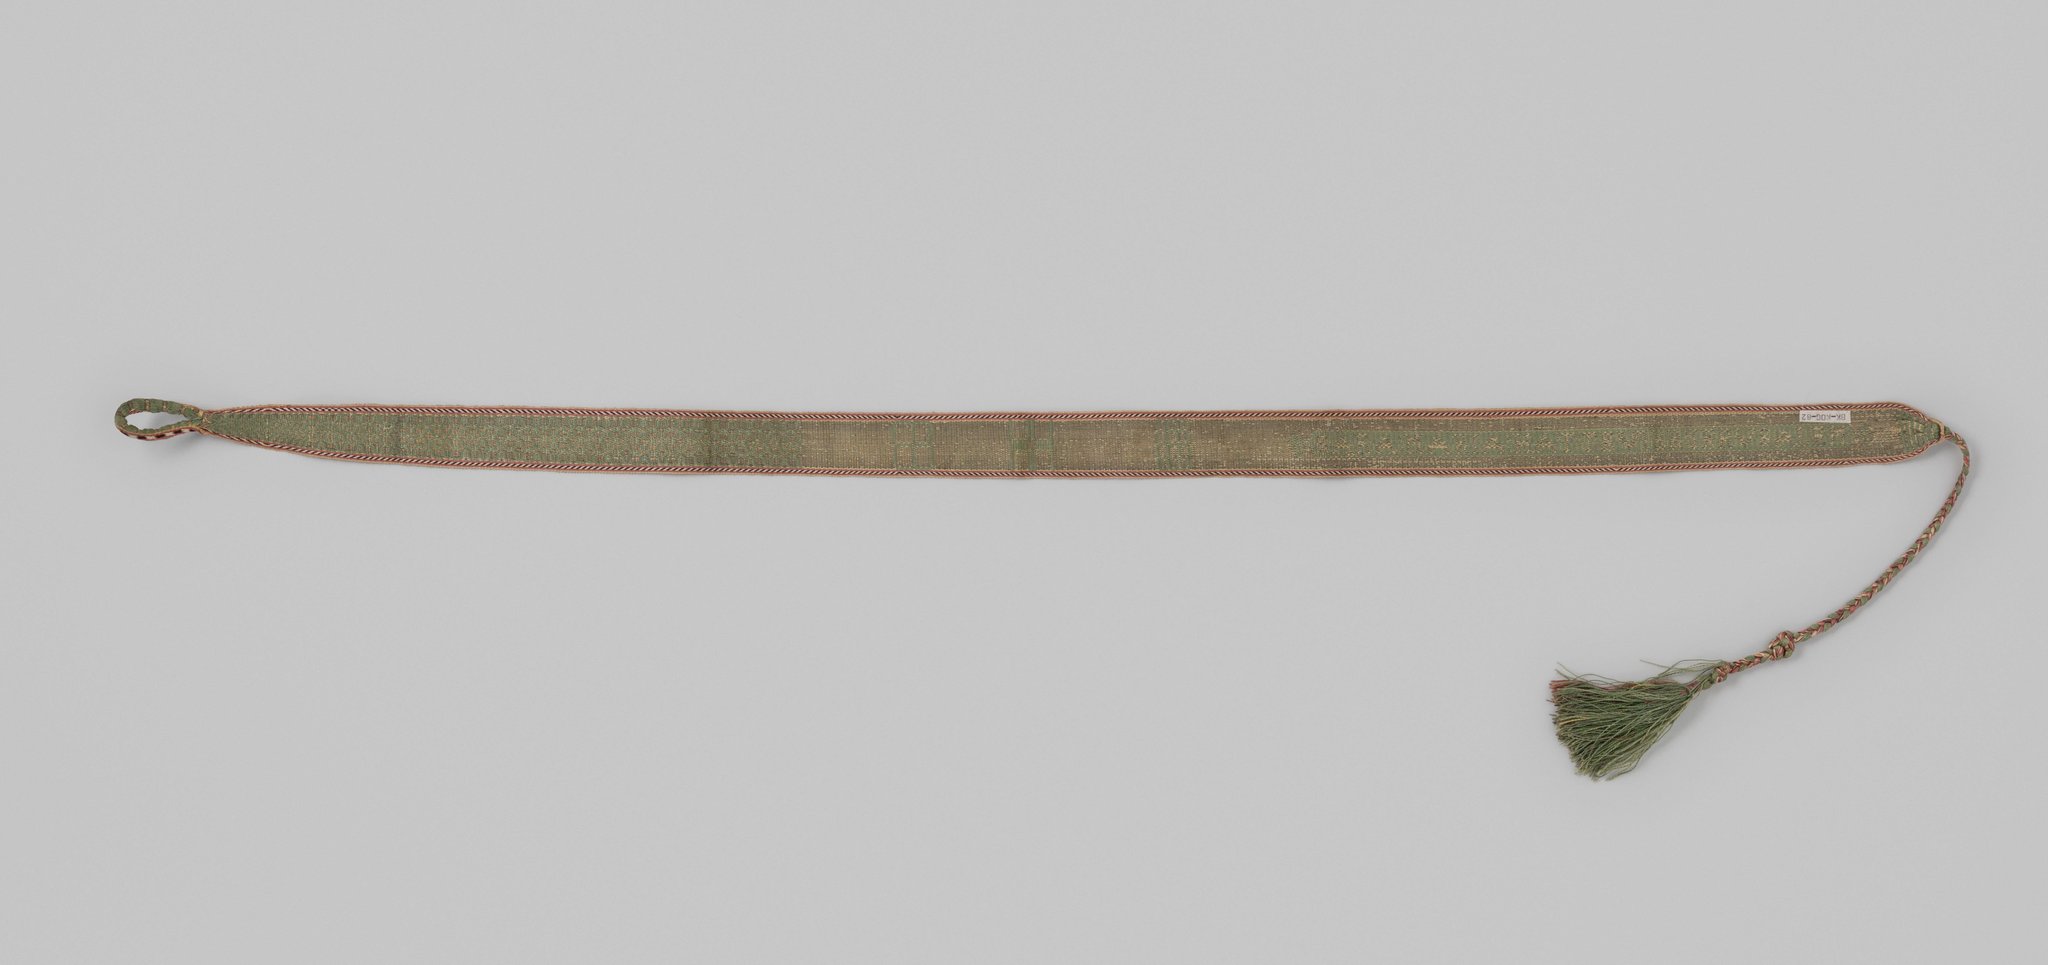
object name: cingulum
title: Kousenband of cingulum, groen met goud gebrocheerd; met de tekst SARA MARIA HATTEVIER JERUSALEM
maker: Anonymous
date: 1677-1700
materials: gold thread, silk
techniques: braiding, brocade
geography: jerusalem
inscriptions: inscription: ‘SARA MARIA HATTEVIER JERUSALEM’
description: Kousenband of cingulum, groen met goud gebrocheerd. In gouden letters tegen een groene achtergrond is de tekst SARA MARIA HATTEVIER JERUSALEM te lezen. Langs de randen lopen twee rode/ roze strepen. Het ene uiteinde van de band heeft een lus, het andere een gevlochten koord waaraan een kwast.